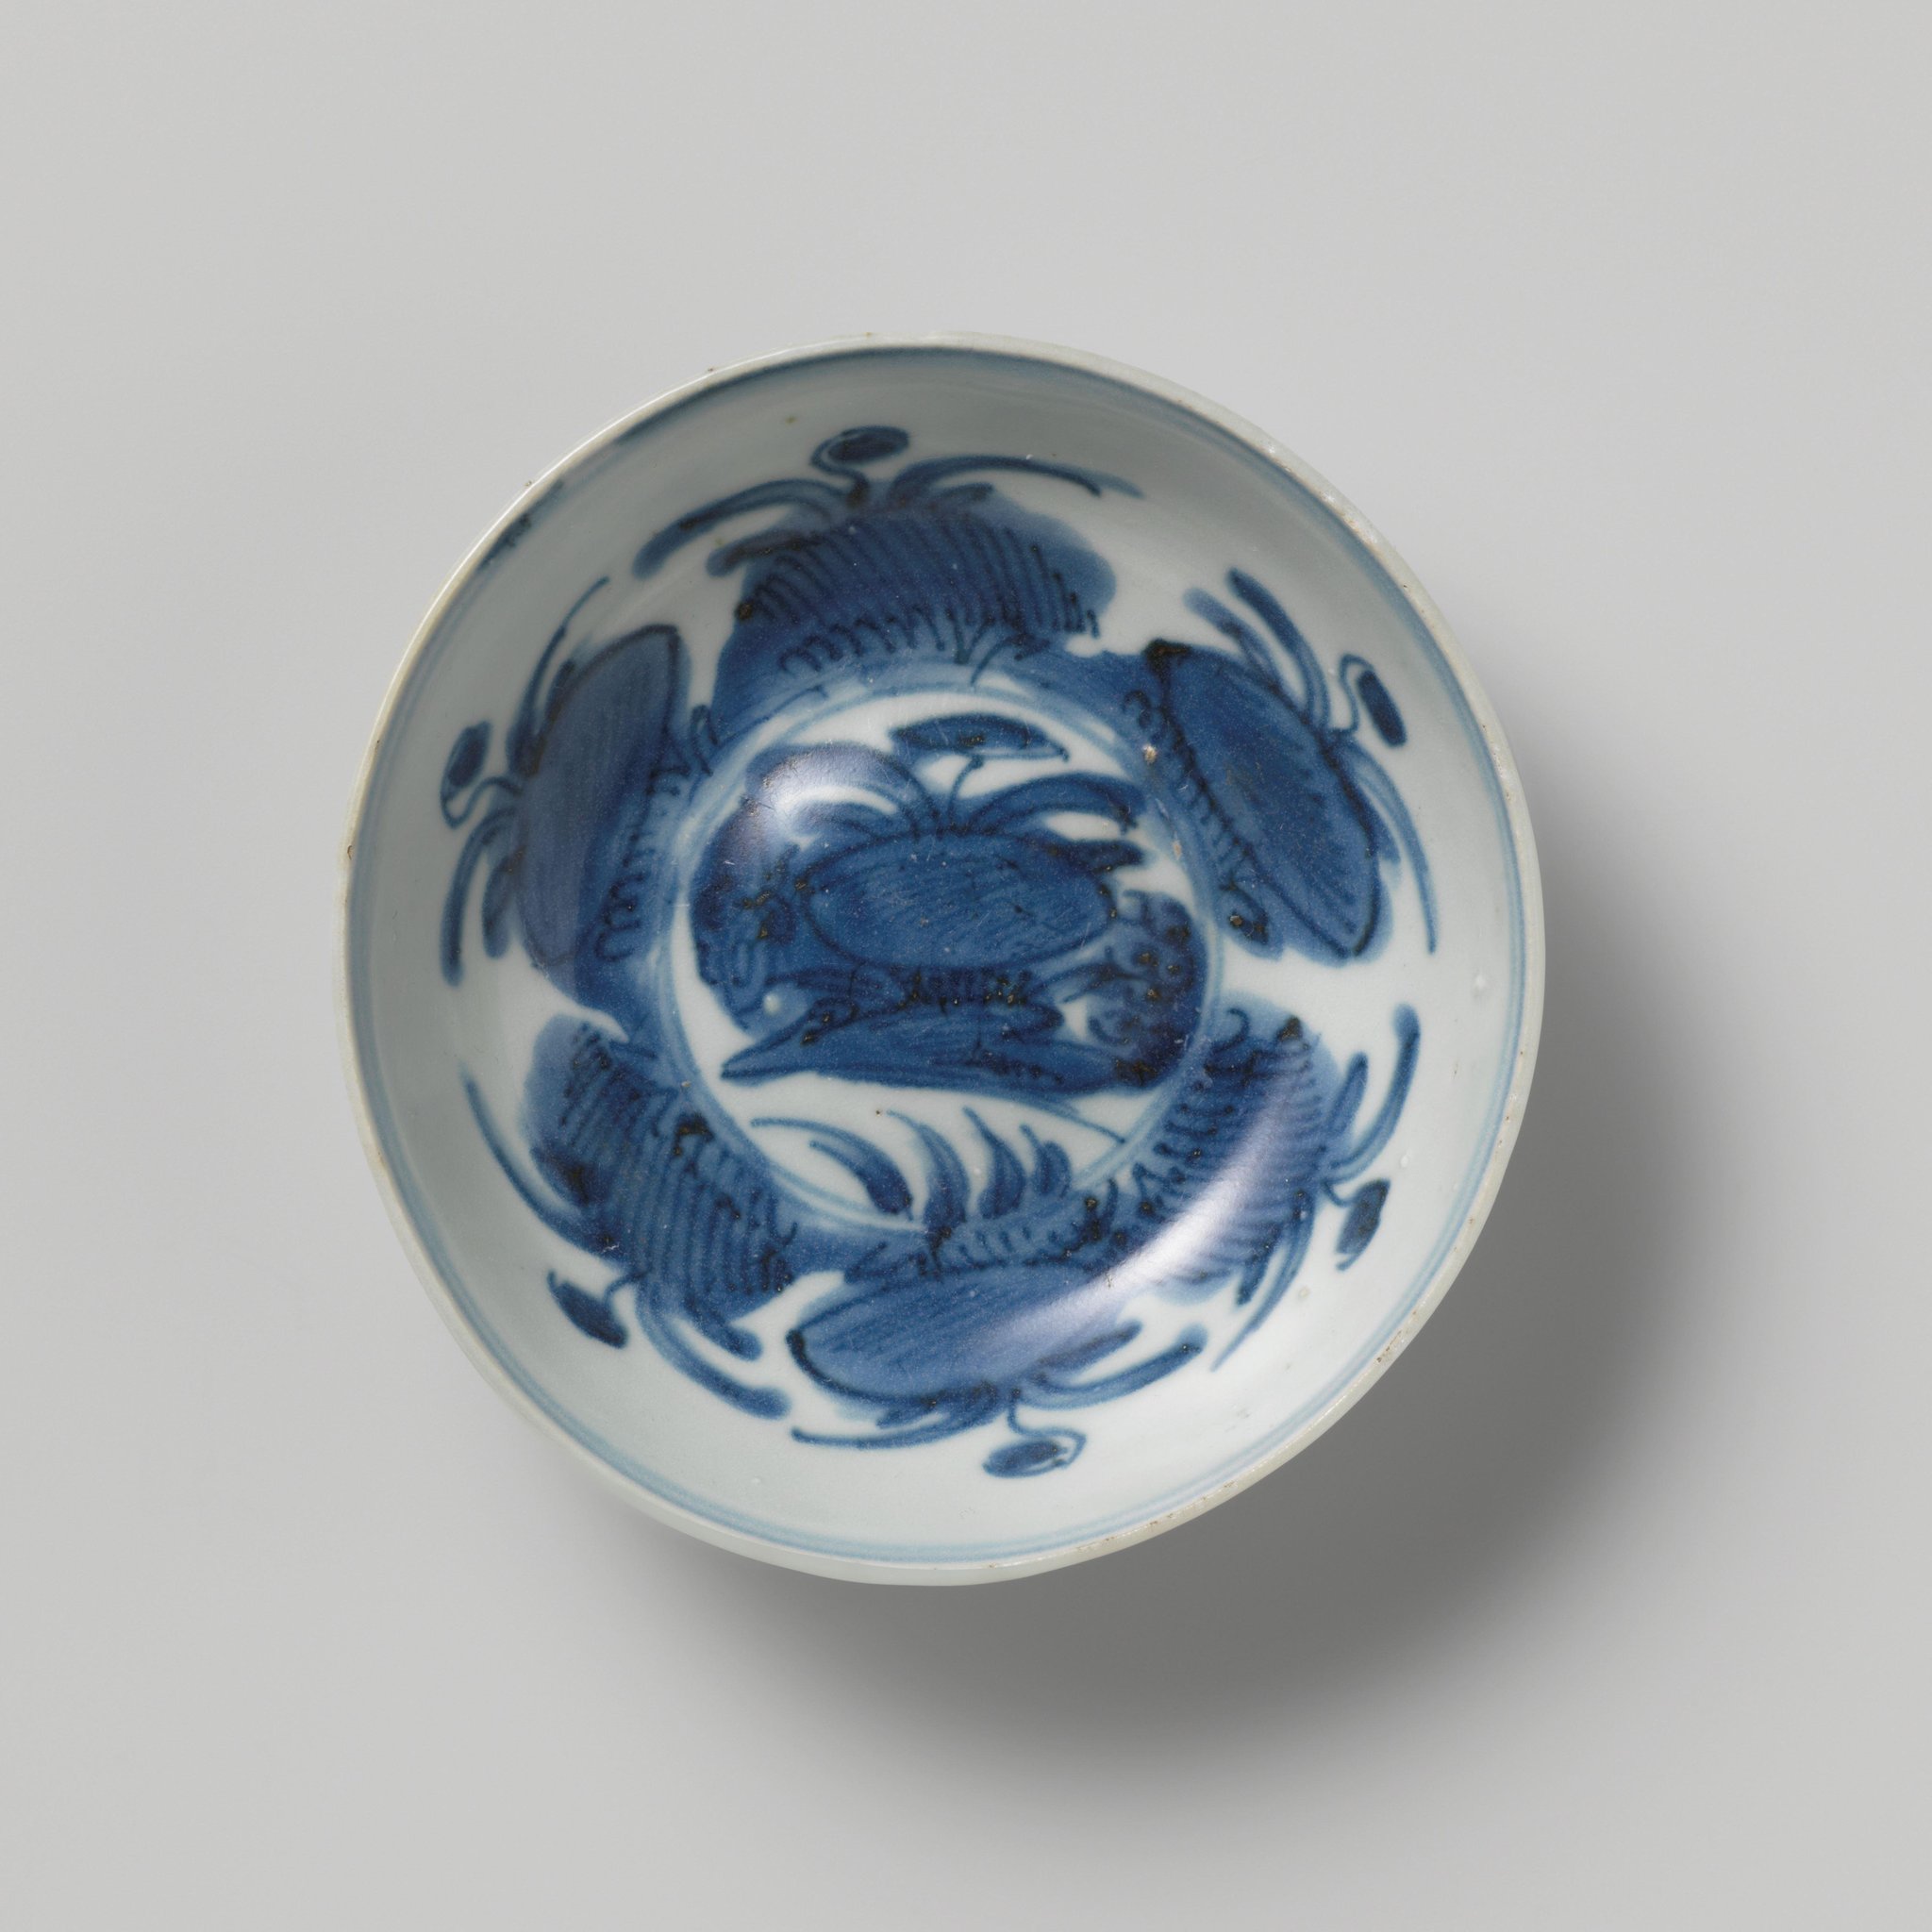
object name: platter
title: Schotel uit V.O.C.-schip de 'Witte Leeuw'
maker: Anonymous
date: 1613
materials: porcelain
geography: jingdezhen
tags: verenigde oostindische compagnie, sint-helena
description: A saucer. The decoration on the inside consists of a flowering lotus plant with a duck underneath in the centre. On the cavetto 6 similar lotus plants are drawn.